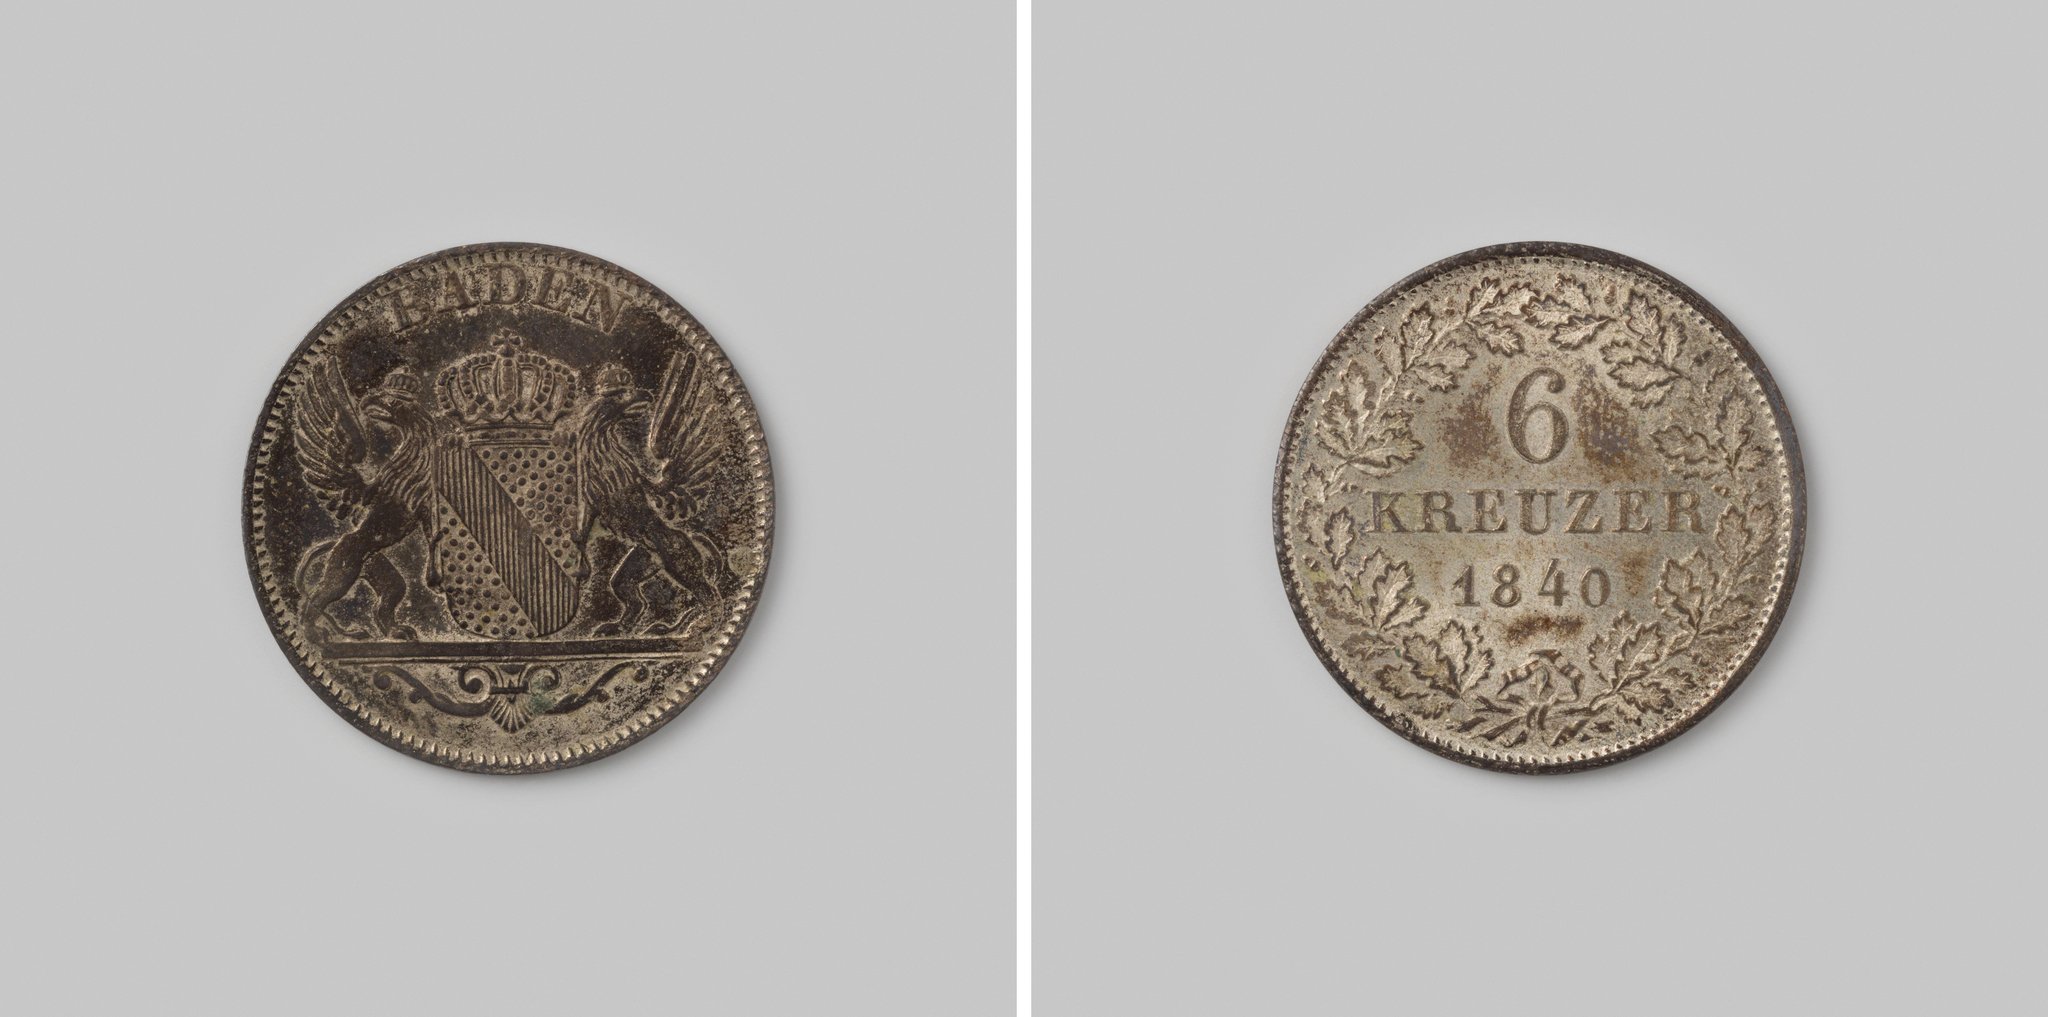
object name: coin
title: 6 Kreuzer uit het groothertogdom Baden van Leopold, 1840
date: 1840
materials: silver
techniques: striking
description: Zilveren munt. Voorzijde: door twee gekroonde griffioenen gehouden gekroond wapenschild. Keerzijde: binnen twee samengebonden takken waarde-aanduiding in twee regels. Daaronder jaartal. Kartelrand.